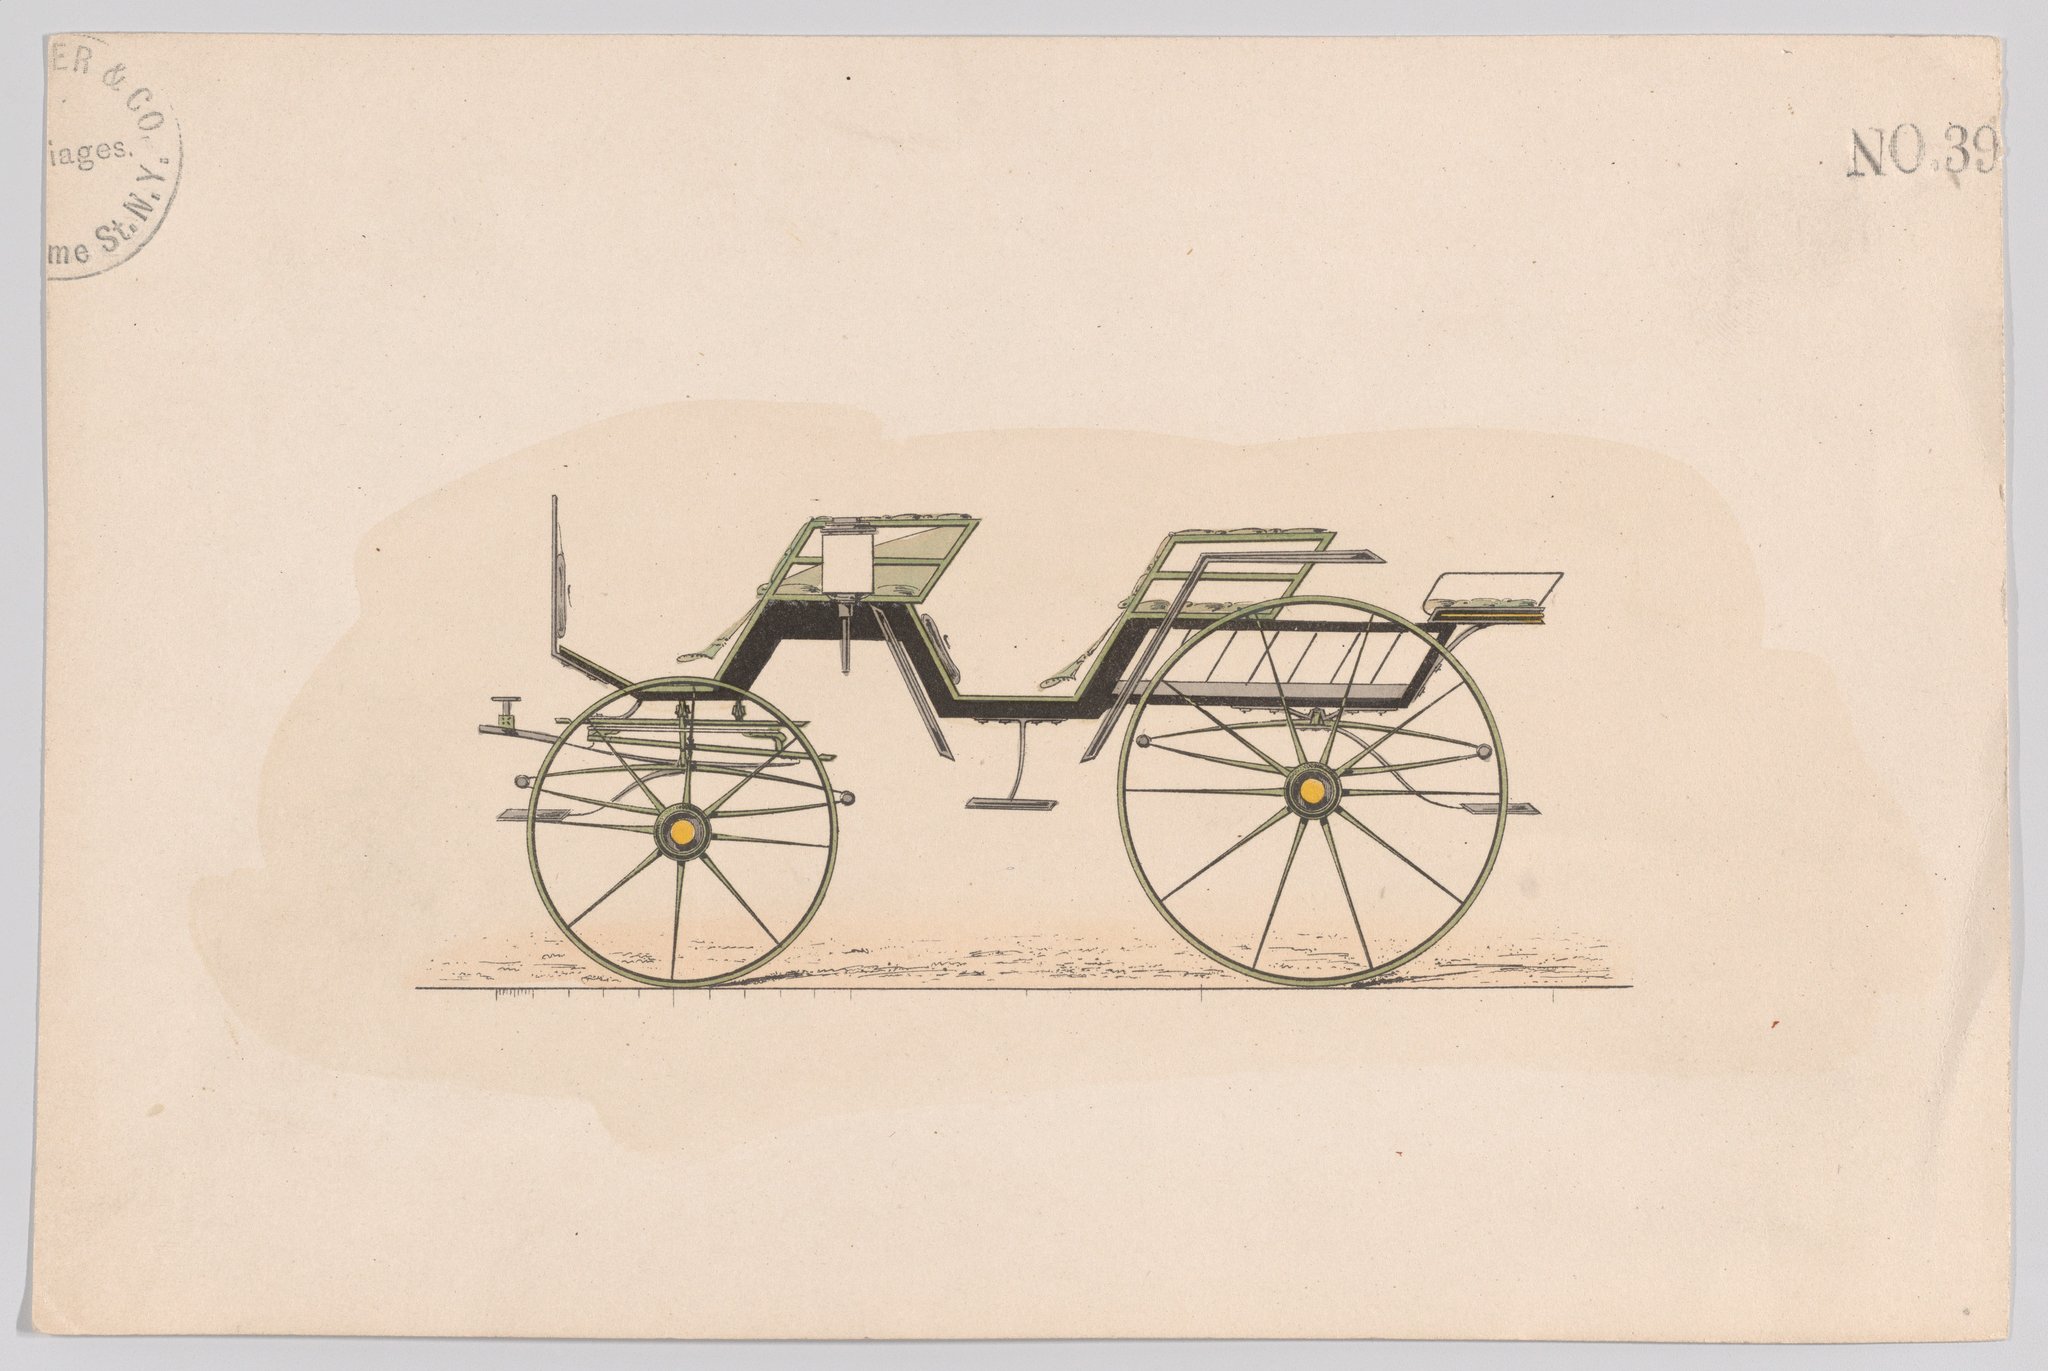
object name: print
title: Phaeton #30**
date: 1880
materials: gum arabic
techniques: hand coloring, lithograph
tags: carriages